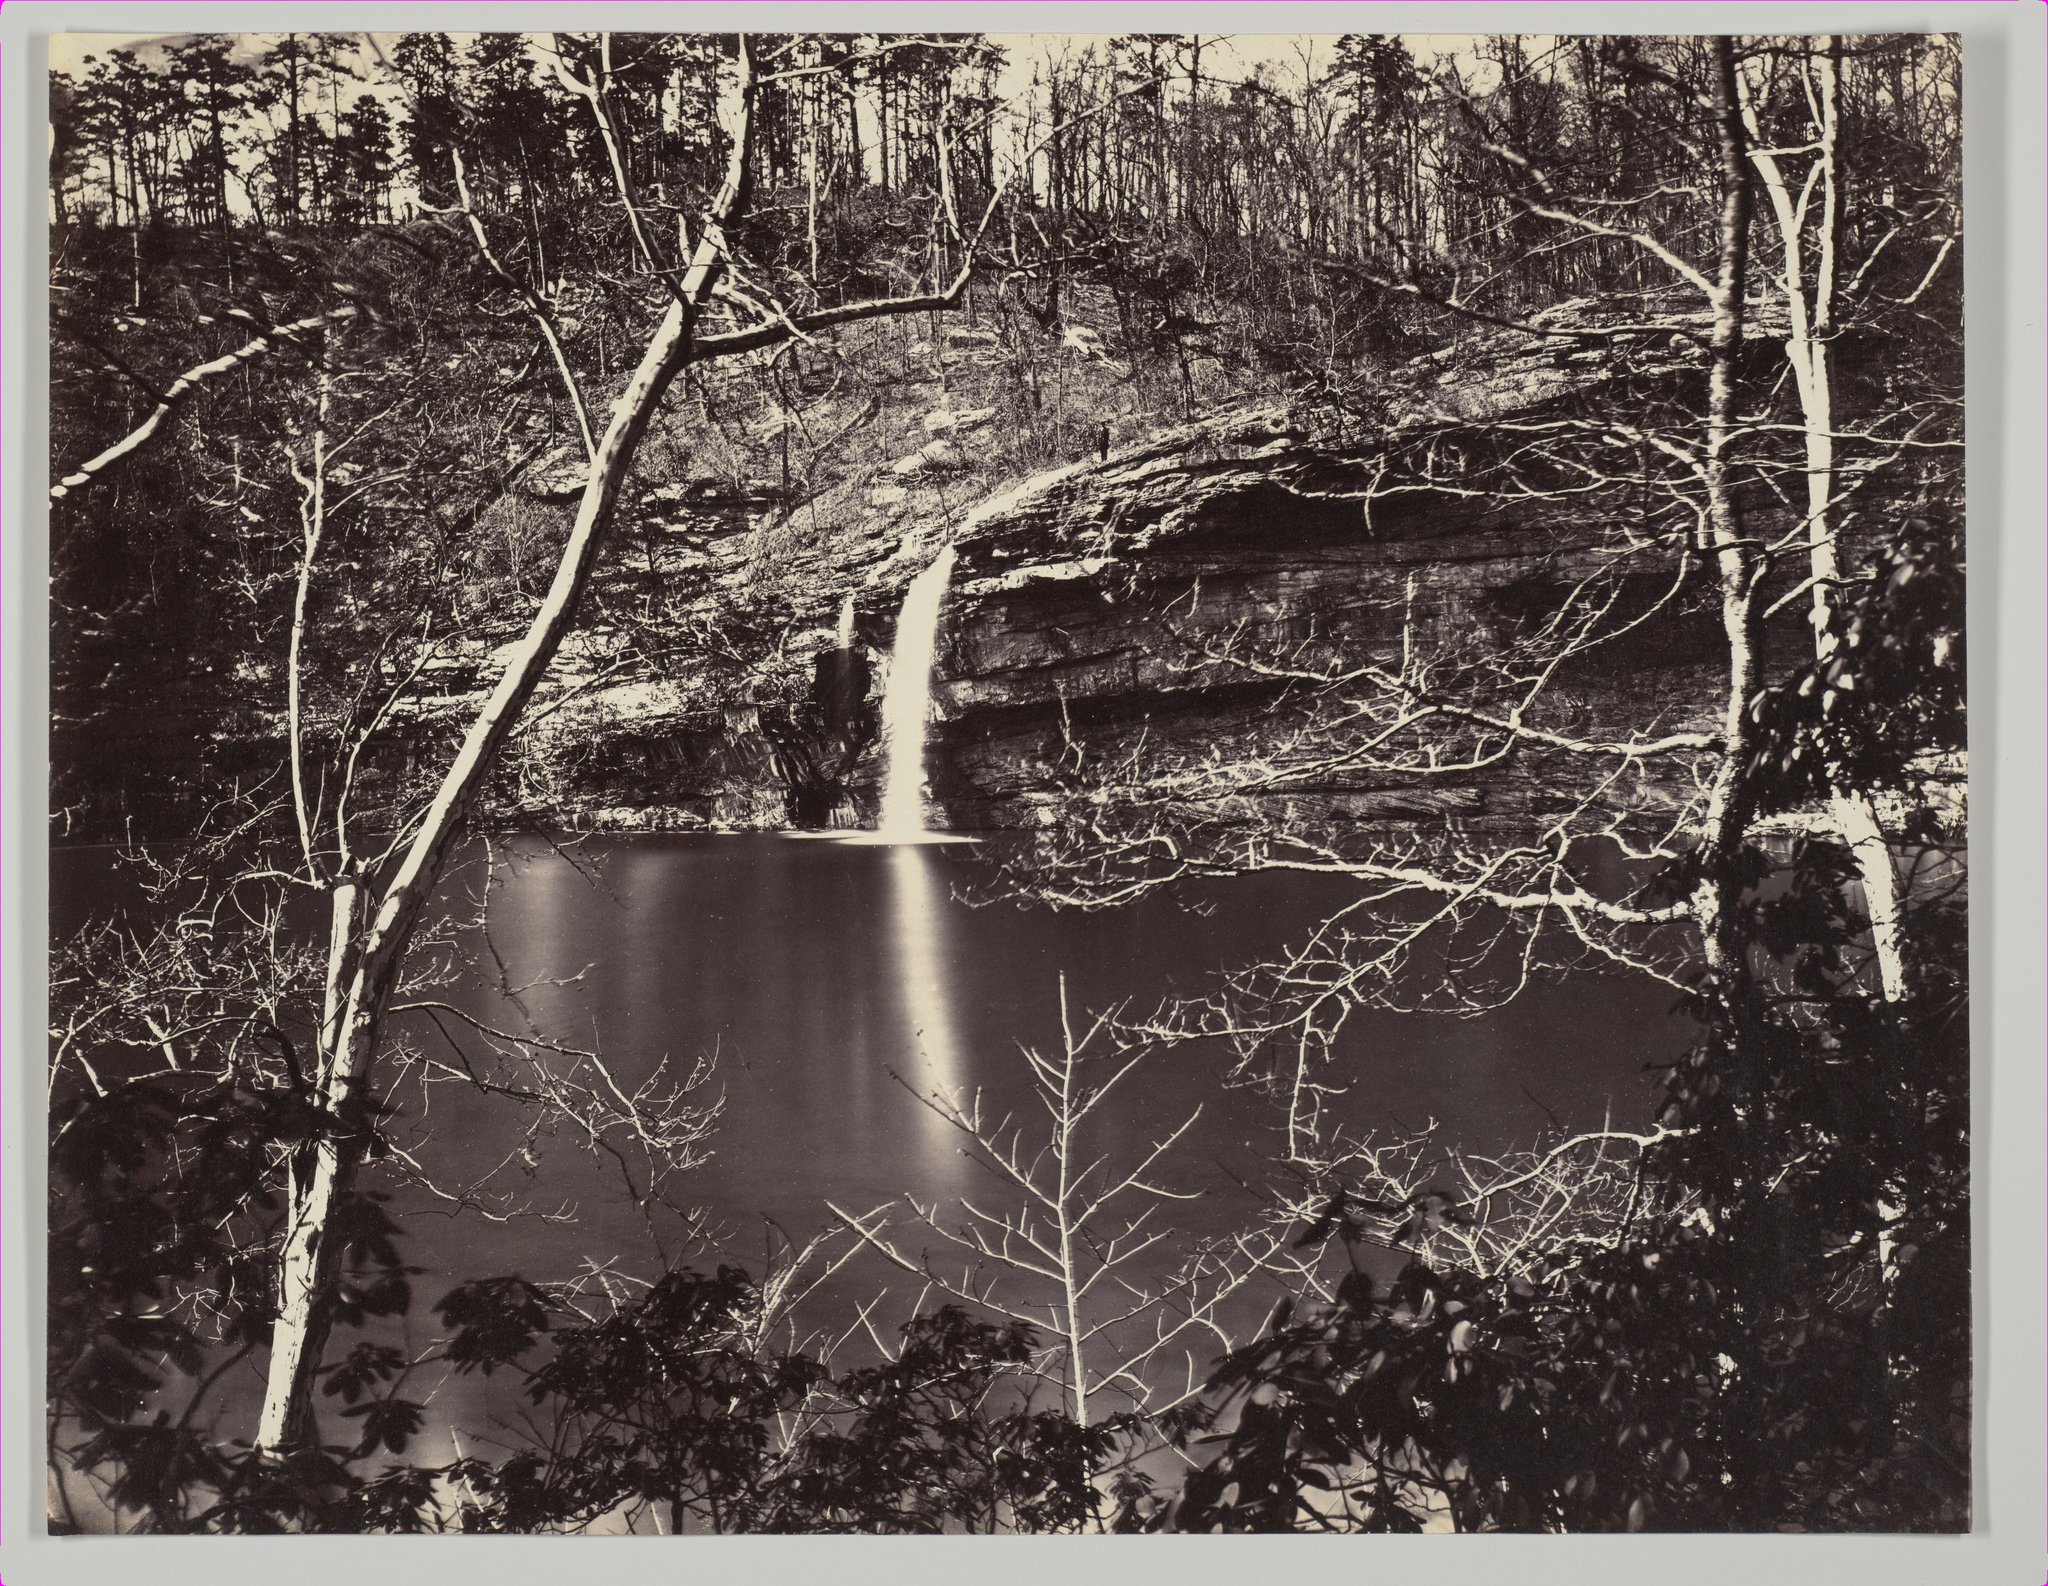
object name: photograph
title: Lake Linangua, 14 miles from Chattanooga, Tennessee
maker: george n. barnard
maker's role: artist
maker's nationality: american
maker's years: 1819-1902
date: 1864-1866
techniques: albumen silver print, glass negative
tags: american civil war